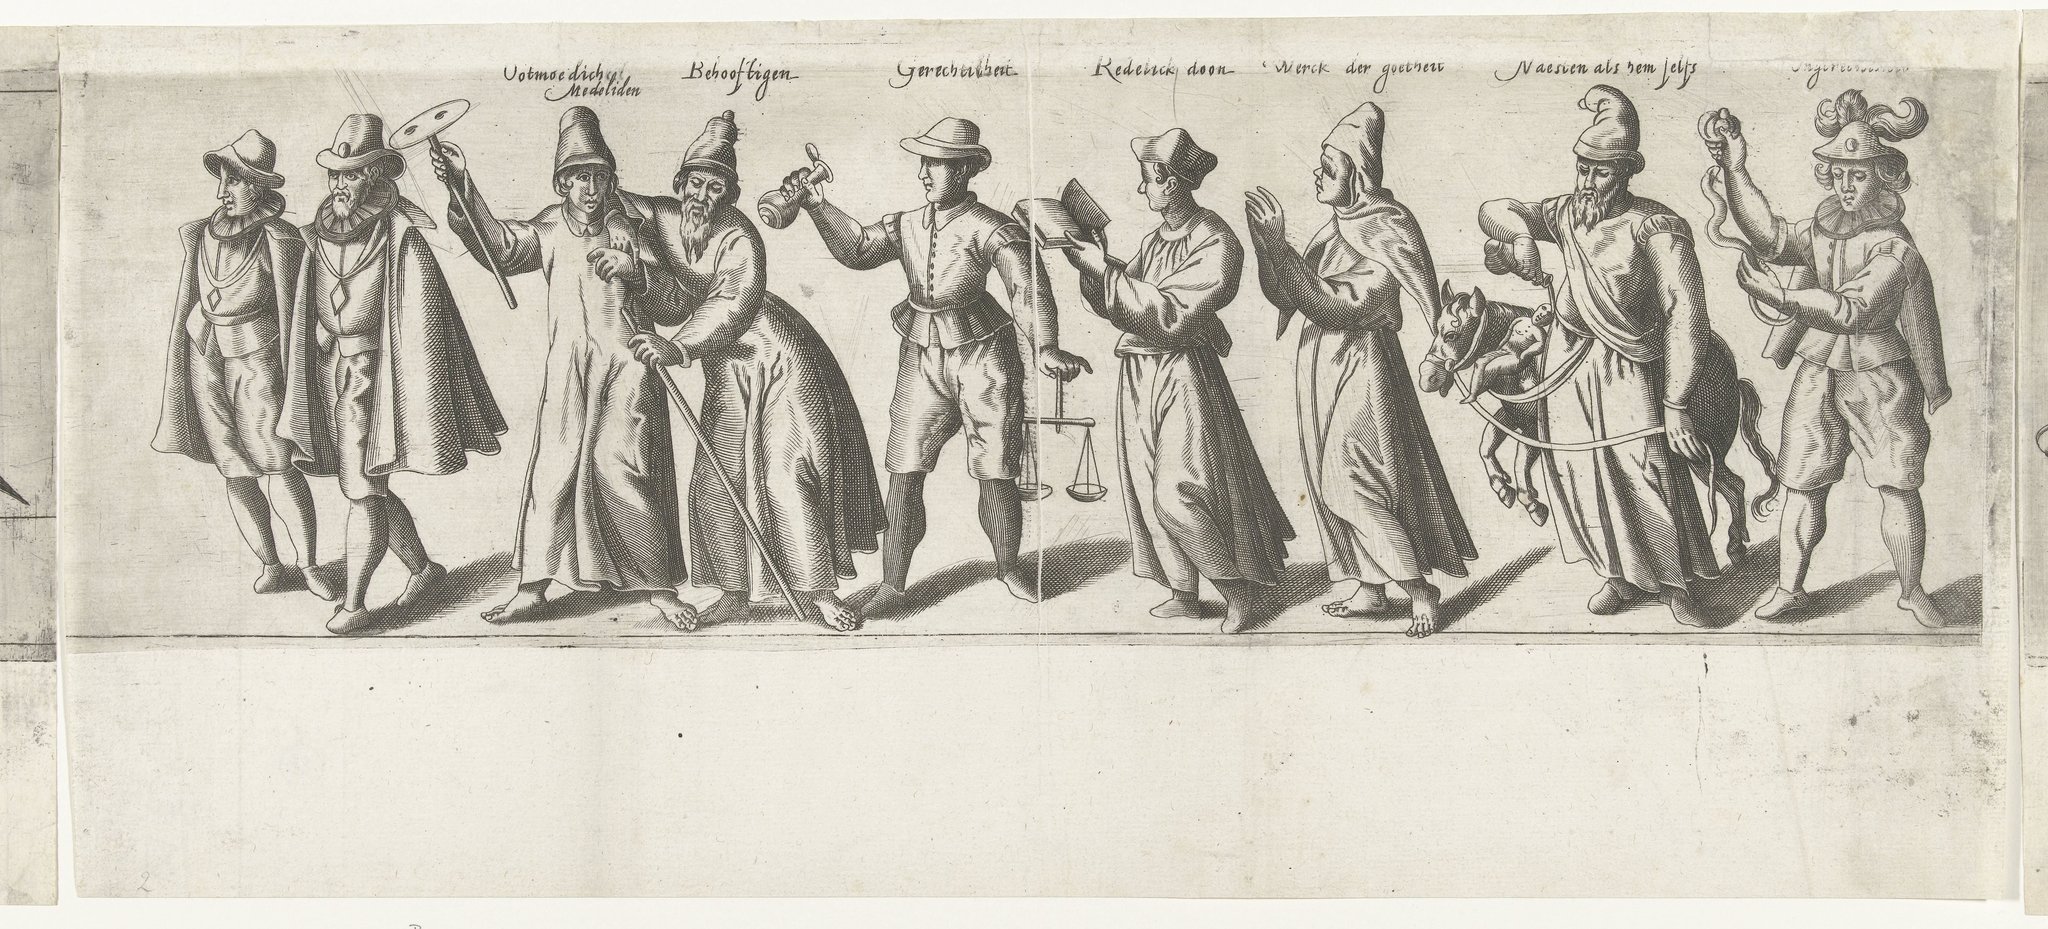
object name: print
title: Optocht door de rederijkerskamer De Sonnebloem uit Kethel (tweede deel), 1607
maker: Anonymous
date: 1607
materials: paper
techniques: engraving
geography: northern netherlands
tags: chamber of rhetoric (dutch: 'rederijkerskamer'), festivities (+ parade, pageant, cavalcade ~ festive activities), haarlem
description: Gebruikt als illustratie in: Const-thoonende ivweel, by de loflijcke stadt Haerlem, ten versoecke van Trou moet blijcken, in't licht gebracht. : Waer inne duydelick verclaert ende verthoont wordt alles wat den mensche mach wecken om den armen te troosten, ende zijnen naesten by te staen. : In twaelf spelen van sinne ... in redenrijck naar de volgende voorgegevene caerte van 't speel-korenken, Zacharias Heyns, Zwolle 1607. Los fragment, bedoeld om samen met de andere delen tot een fries gemonteerd te worden.